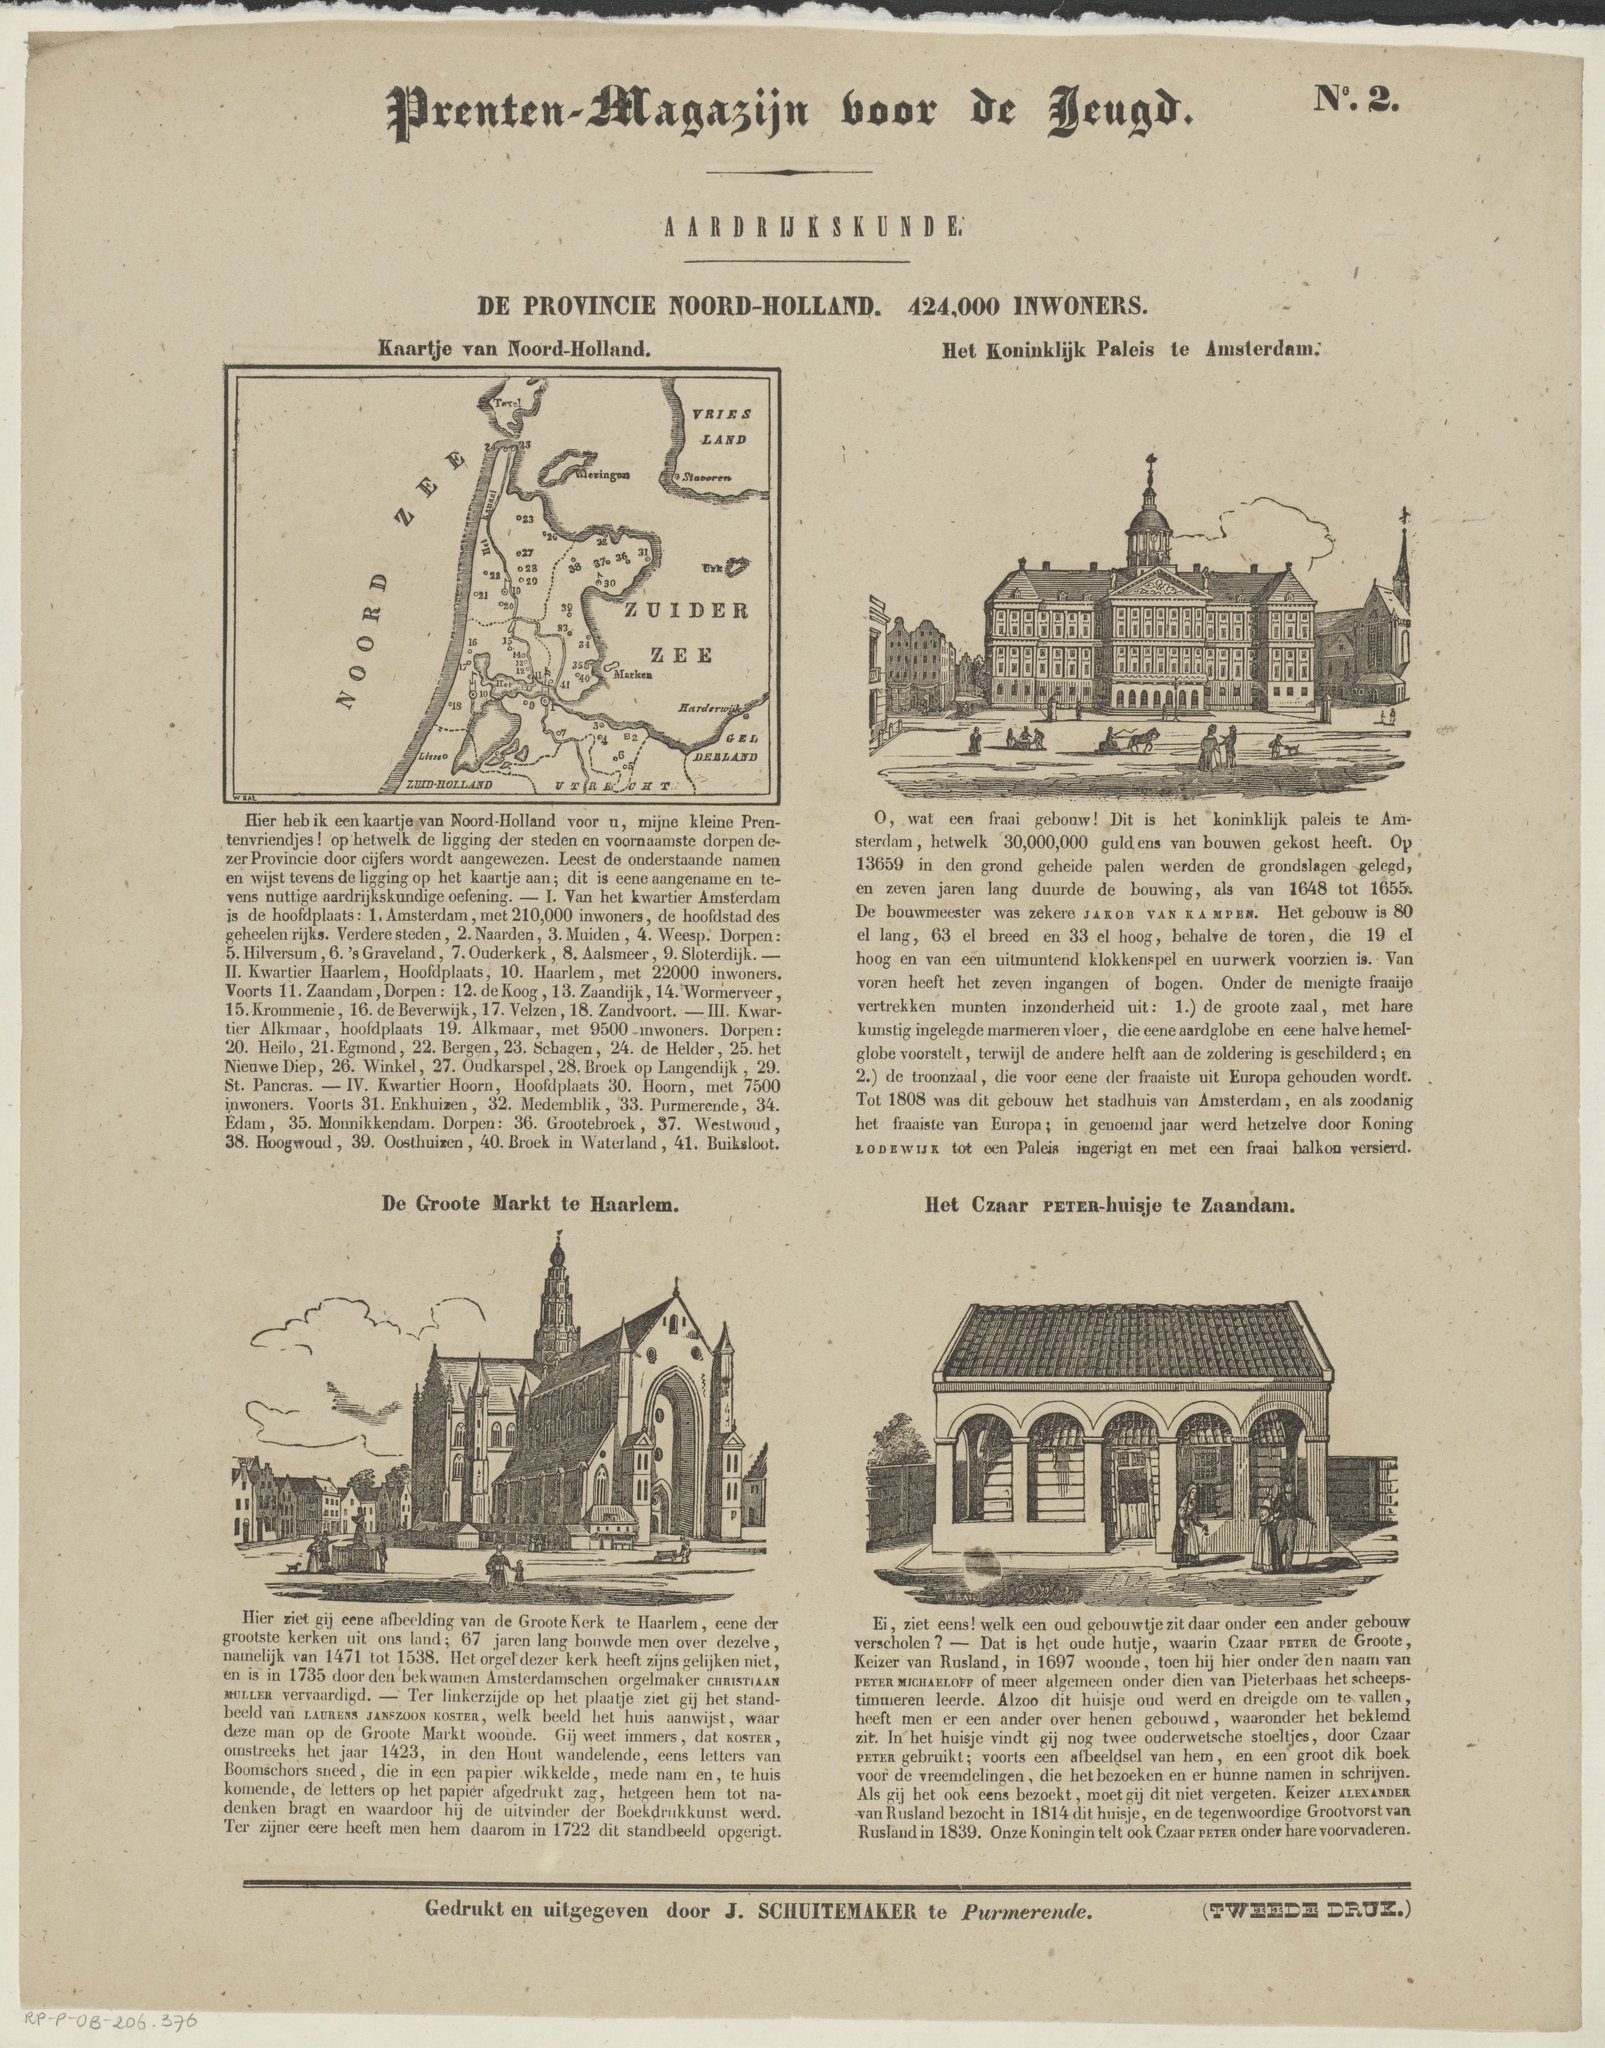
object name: popular print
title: Prenten-magazijn voor de jeugd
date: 1842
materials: paper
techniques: letterpress printing, engraving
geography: purmerend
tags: maps, atlases, palace, roman catholic church, royal palace of amsterdam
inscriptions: collector's mark: Lugt 2760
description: Blad met 4 voorstellingen over de provincie Noord-Holland met een kaart en belangrijke gebouwen: het Paleis op de Dam te Amsterdam, de Grote Markt in Haarlem en het Czaar Peterhuisje te Zaandam. Boven elke voorstelling een titel en onder elke voorstelling twaalf tot achttien regels tekst. Genummerd rechtsboven: No. 2.